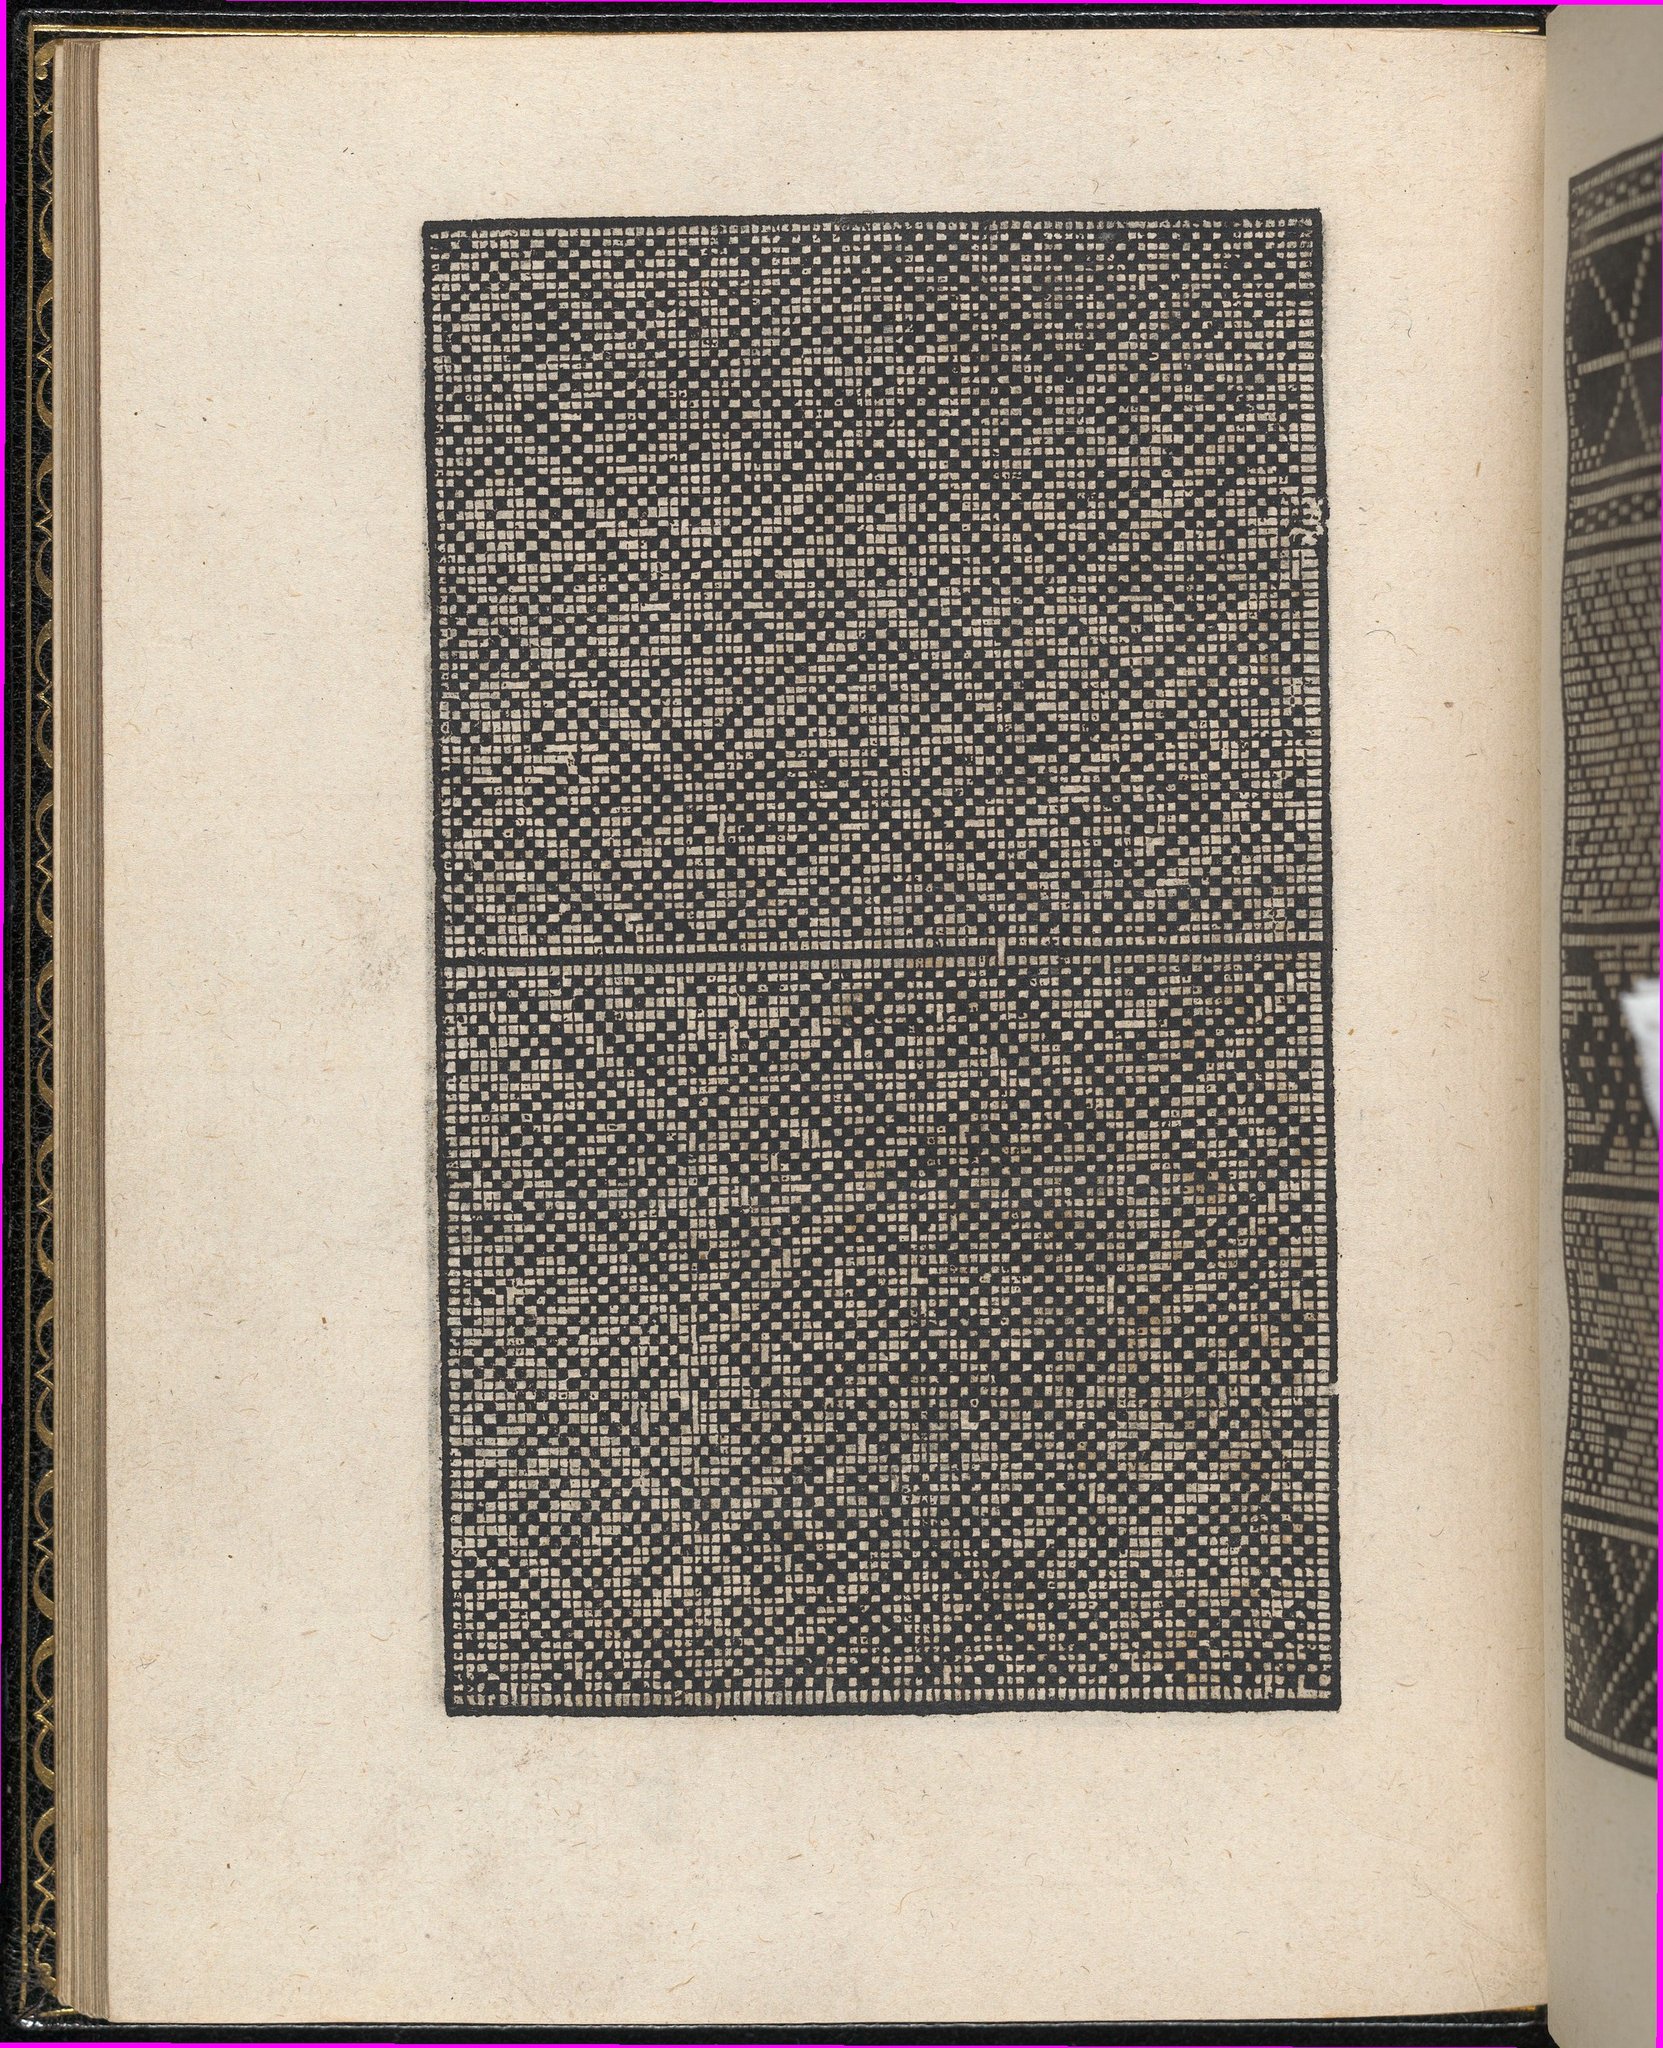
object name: book print ornament architecture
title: Page from Ein new kunstlich Modelbuch...(Page 33v)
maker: peter quentel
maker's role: publisher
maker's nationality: german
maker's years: 1500-1550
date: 1544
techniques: woodcut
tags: ornament